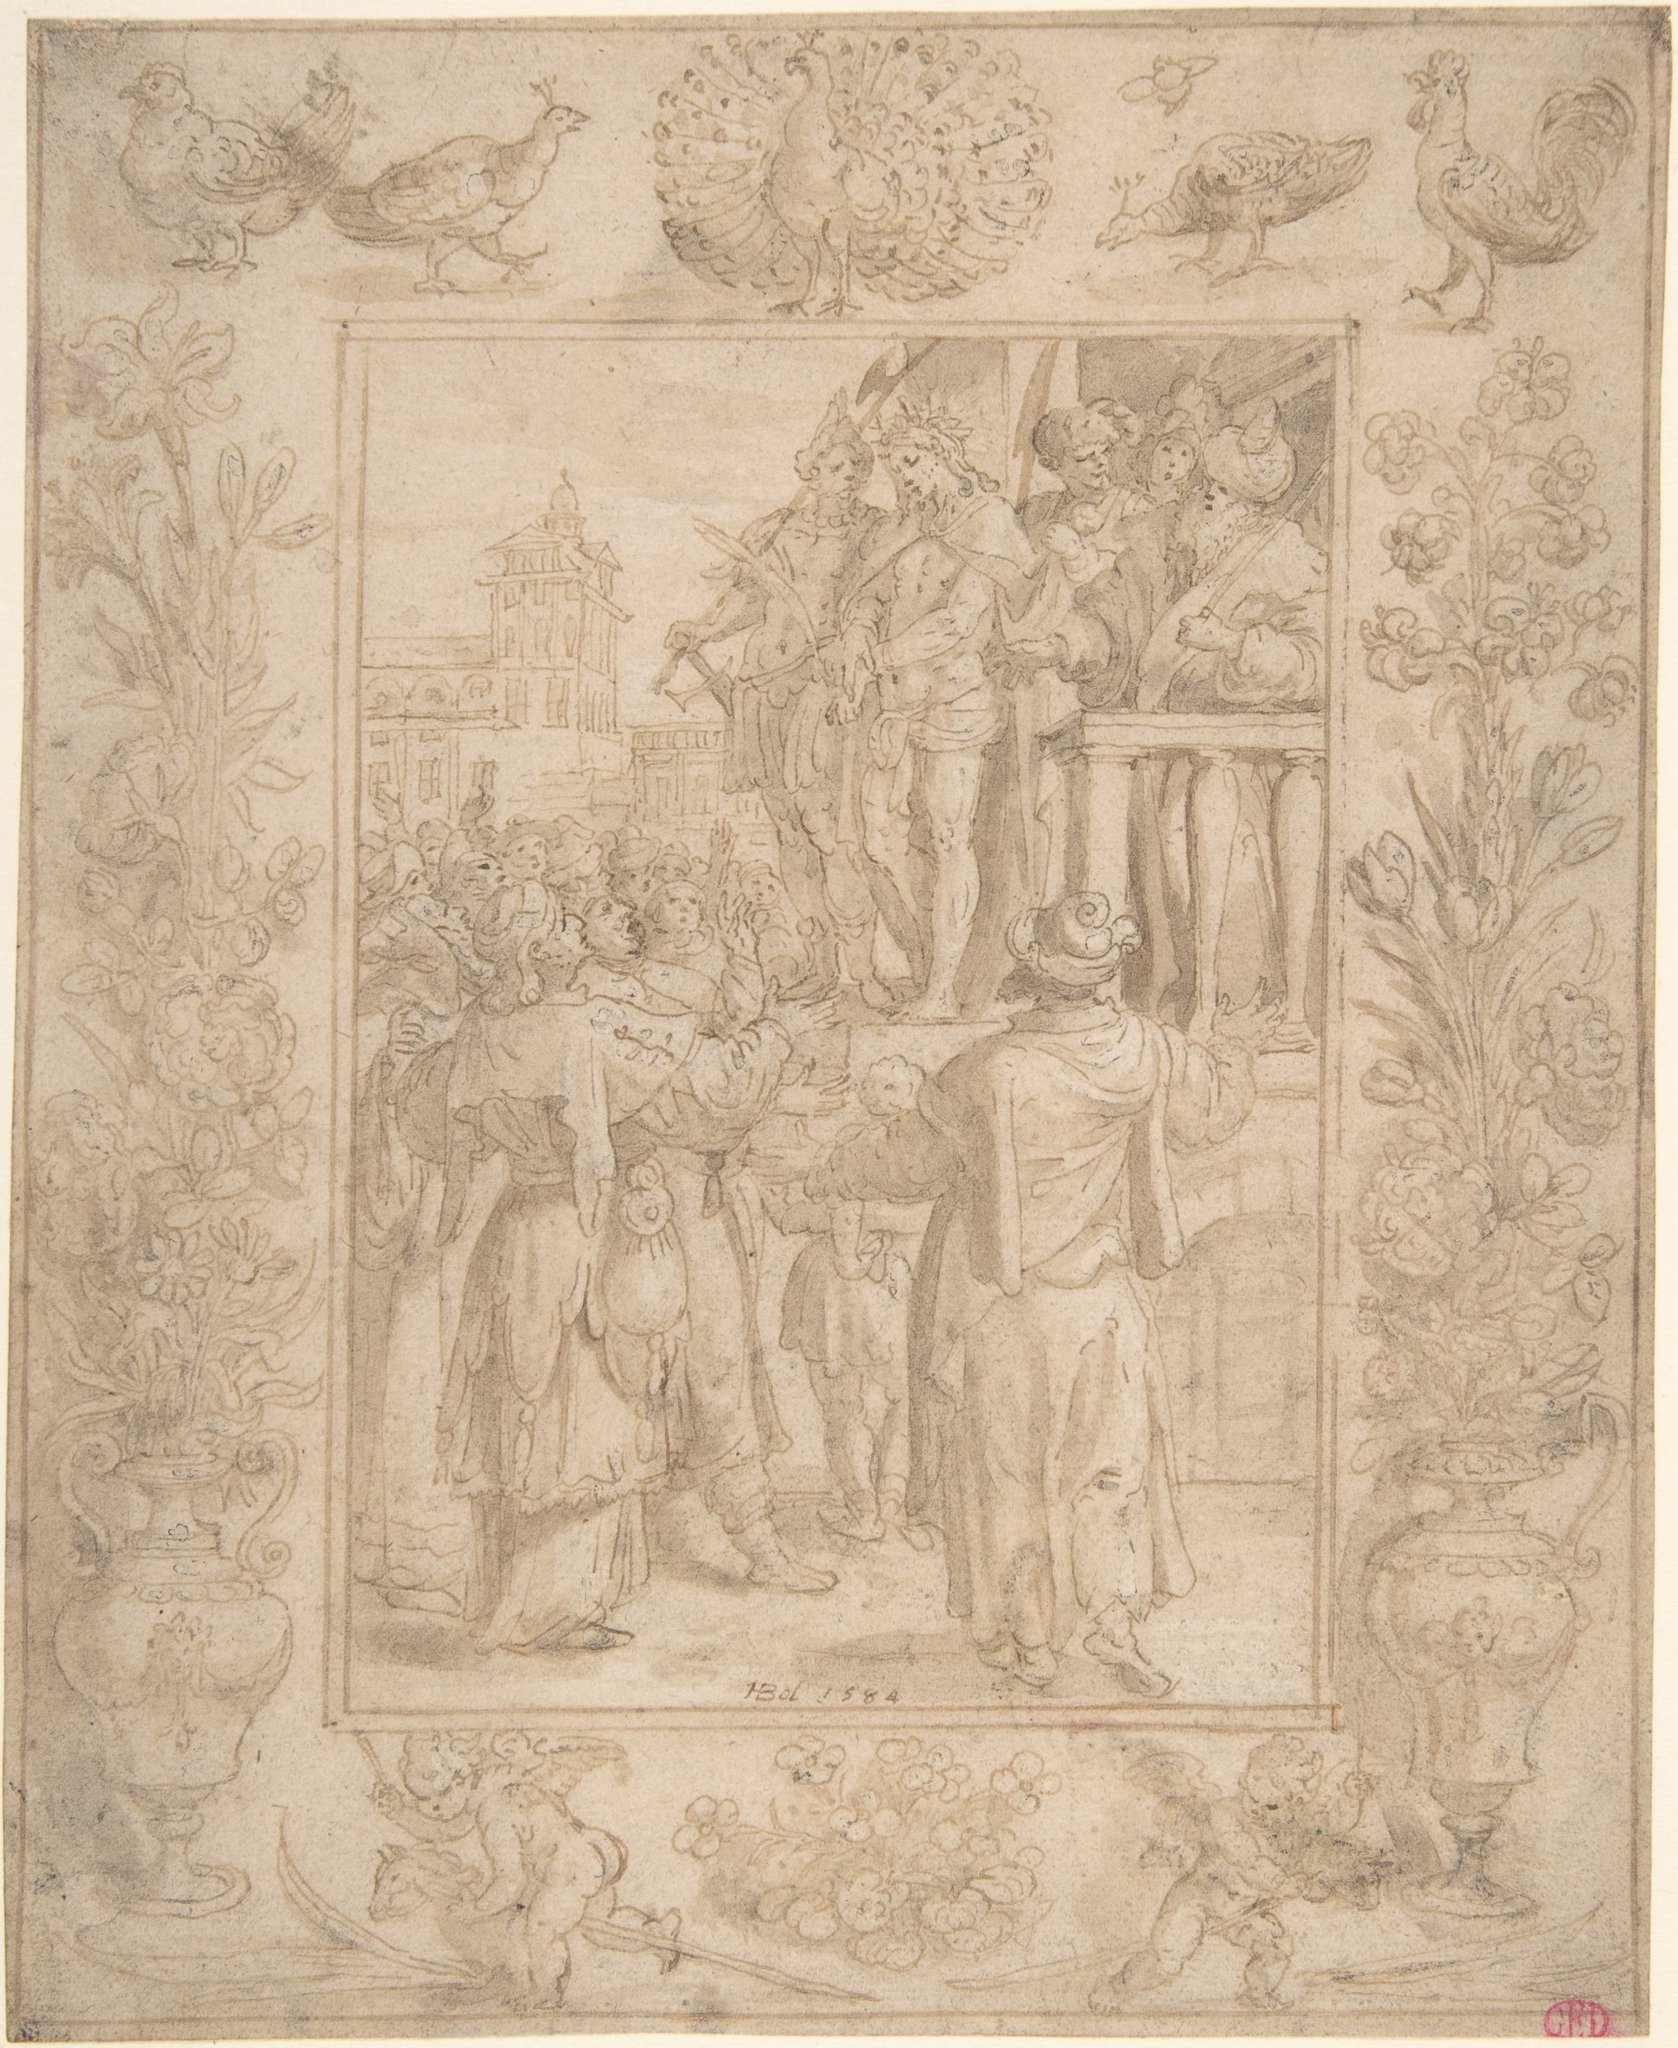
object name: drawing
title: Ecce Homo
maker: maerten de vos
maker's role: artist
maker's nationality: netherlandish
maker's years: 1532-1603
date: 1584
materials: ink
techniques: brush, incising, pen, transfer, wash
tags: peacocks,roosters,flowers,angels,jesus